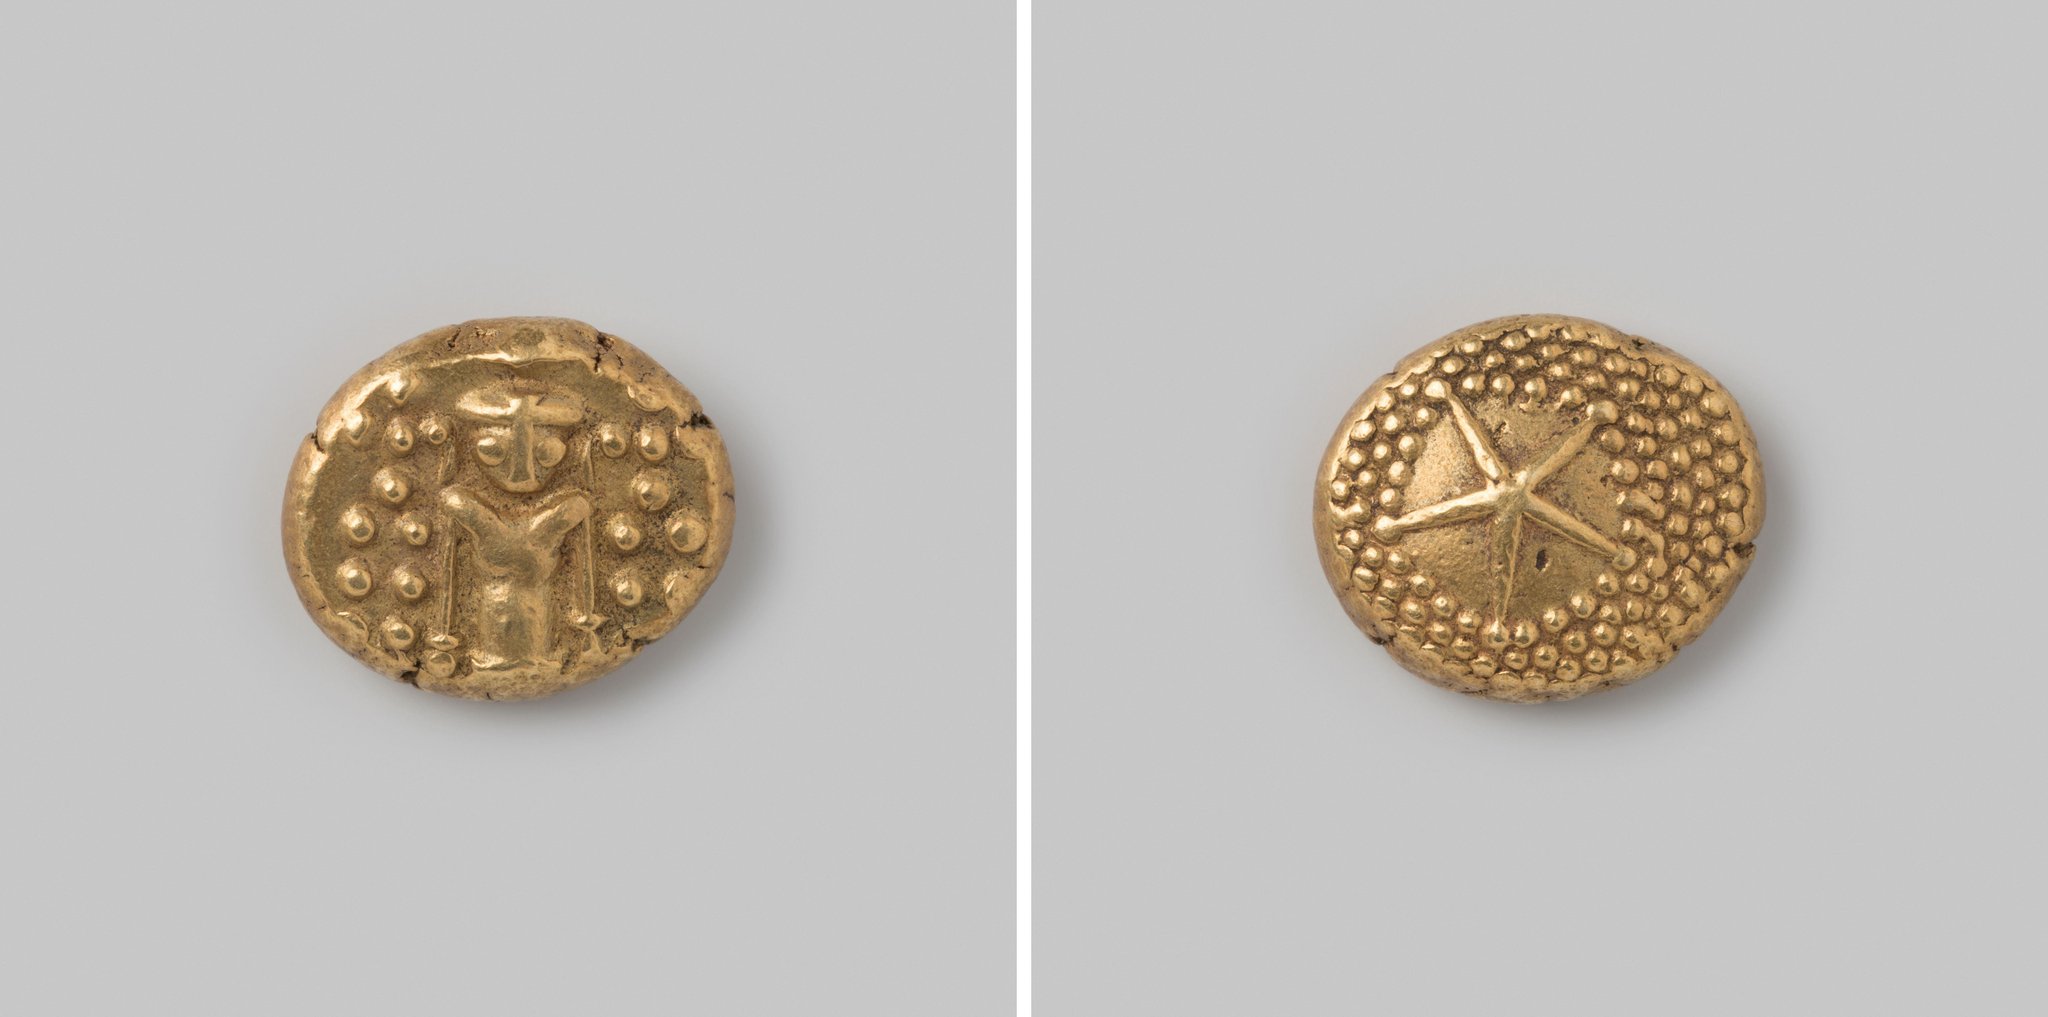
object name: sterpagode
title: Sterpagode voor Madras in India van de Engelse Oostindische Compagnie (EIC), (1740-1807)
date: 1740-1807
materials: gold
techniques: striking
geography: chennai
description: Gouden munt. Voorzijde: een godheid ten halve lijve, staande. Links en rechts van hem stippen. Keerzijde: bolvormig, met binnen een denkbeeldige cirkel een vijfpuntige ster, waaromheen een veld, bezaaid met korrels. Gladde rand.